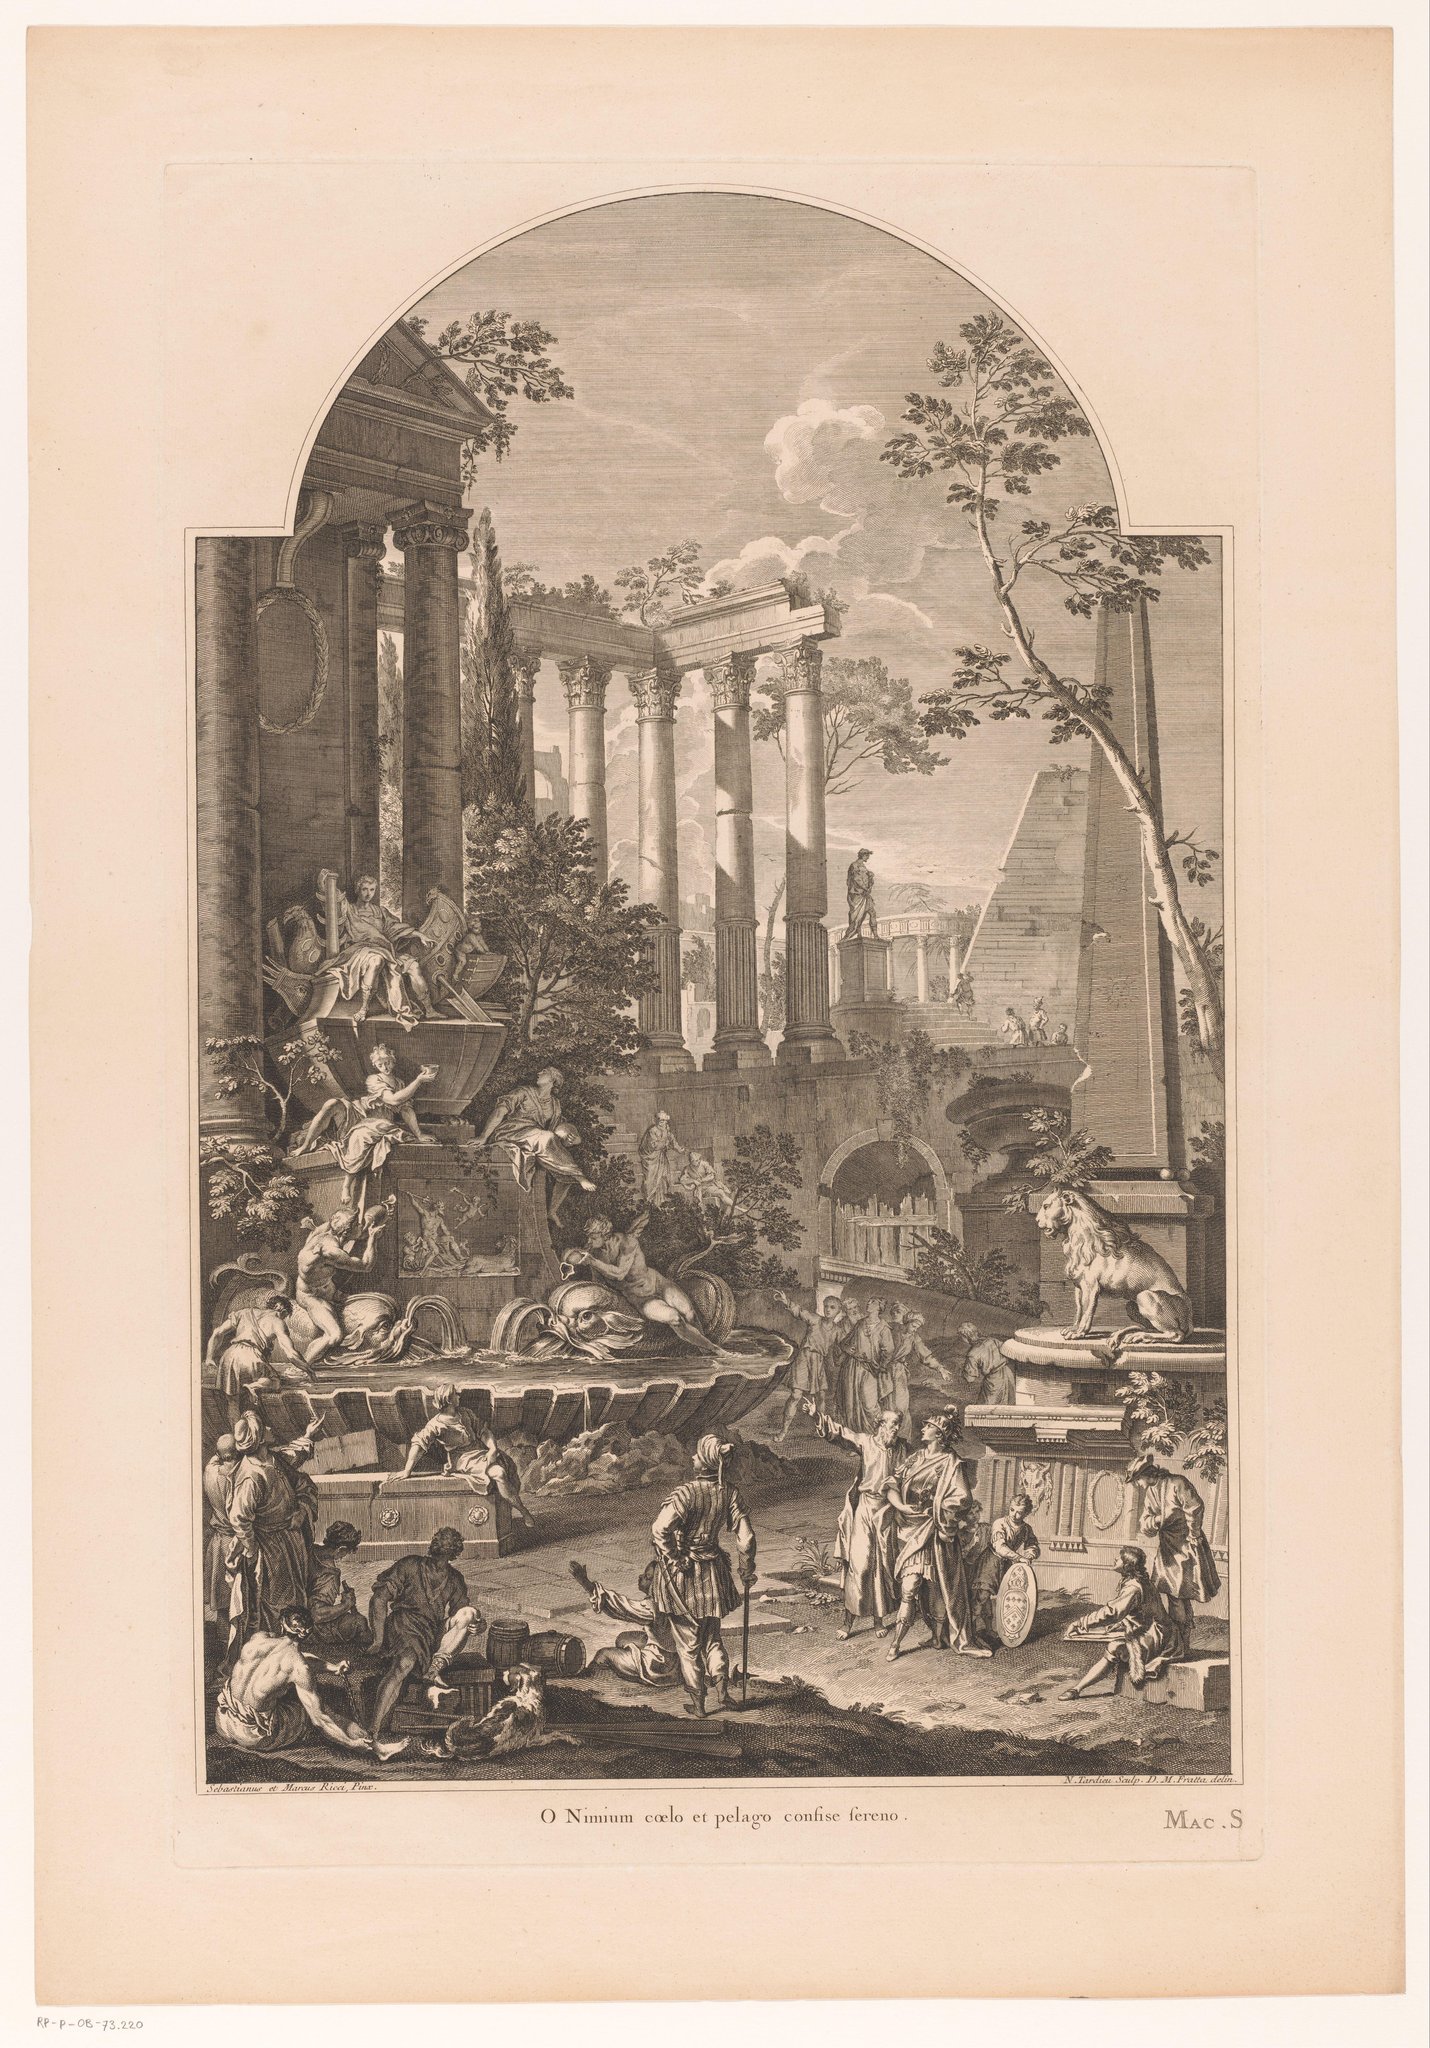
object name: print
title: Allegorische grafmonumenten van illustere Britten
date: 1735-1741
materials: paper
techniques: engraving, etching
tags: obelisk, needle, grave, tomb, ornamental fountain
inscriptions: collector's mark: Lugt 2228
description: Maakt deel uit van een twintigdelige serie met prenten van grafmonumenten van illustere Britten naar schilderijen uit de collectie van de Duke of Richmond. De serie bestaat uit prenten door verschillende kunstenaars en werd eerst uitgegeven door Mac Swiny en daarna door Basan.